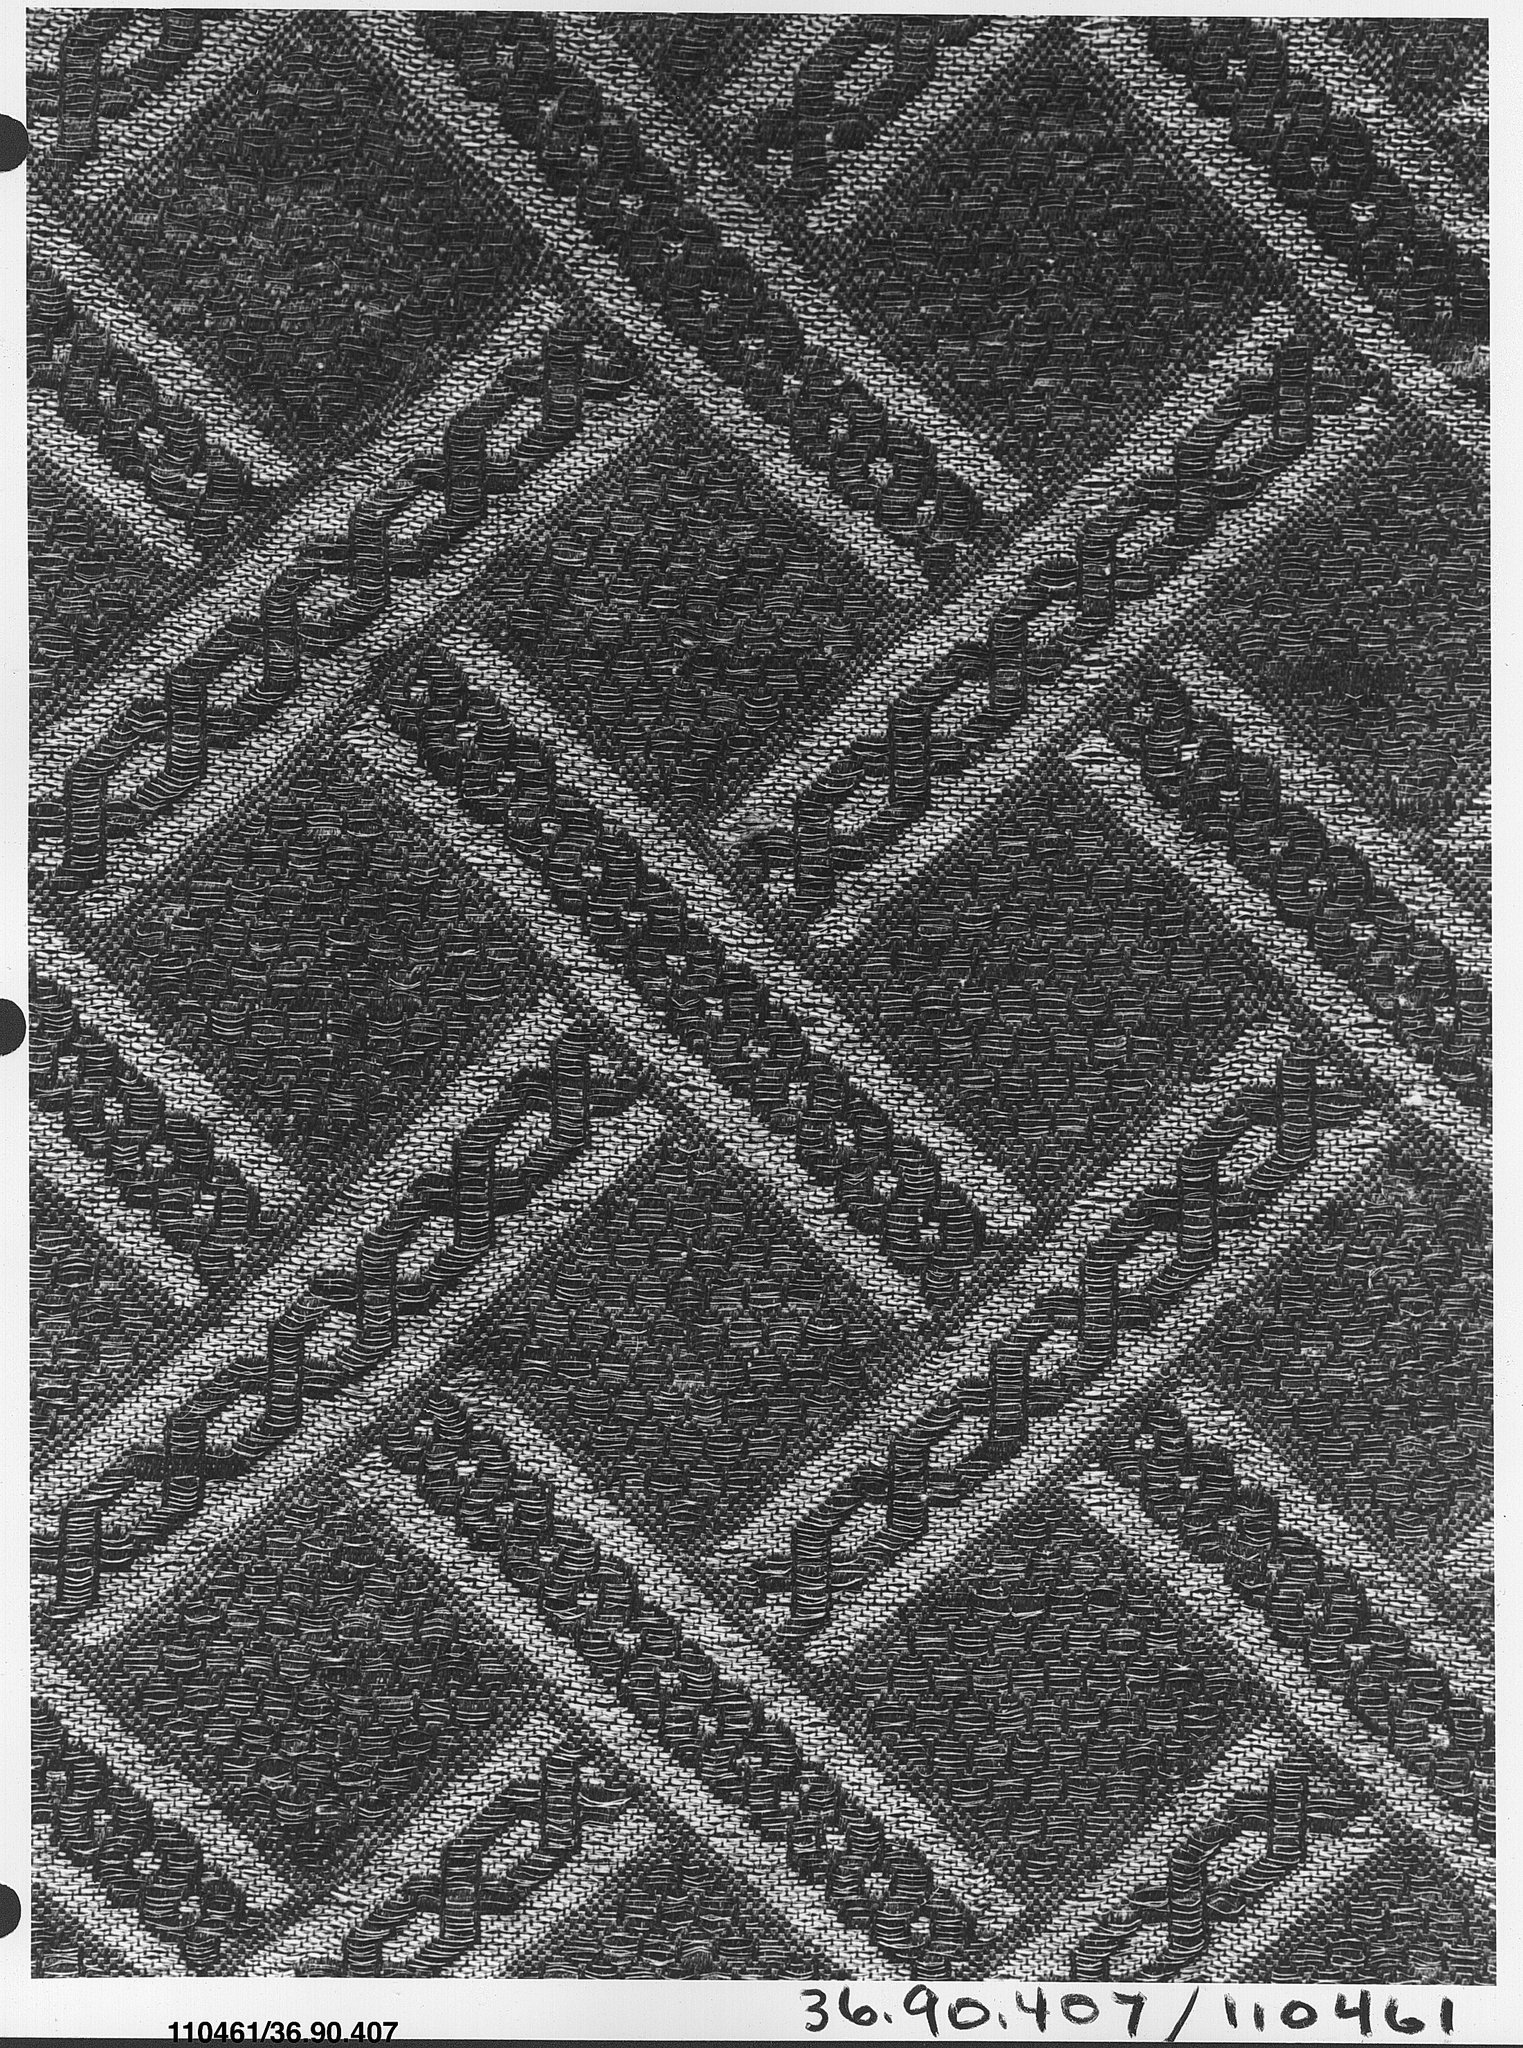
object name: piece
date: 1501-1700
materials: linen, silk